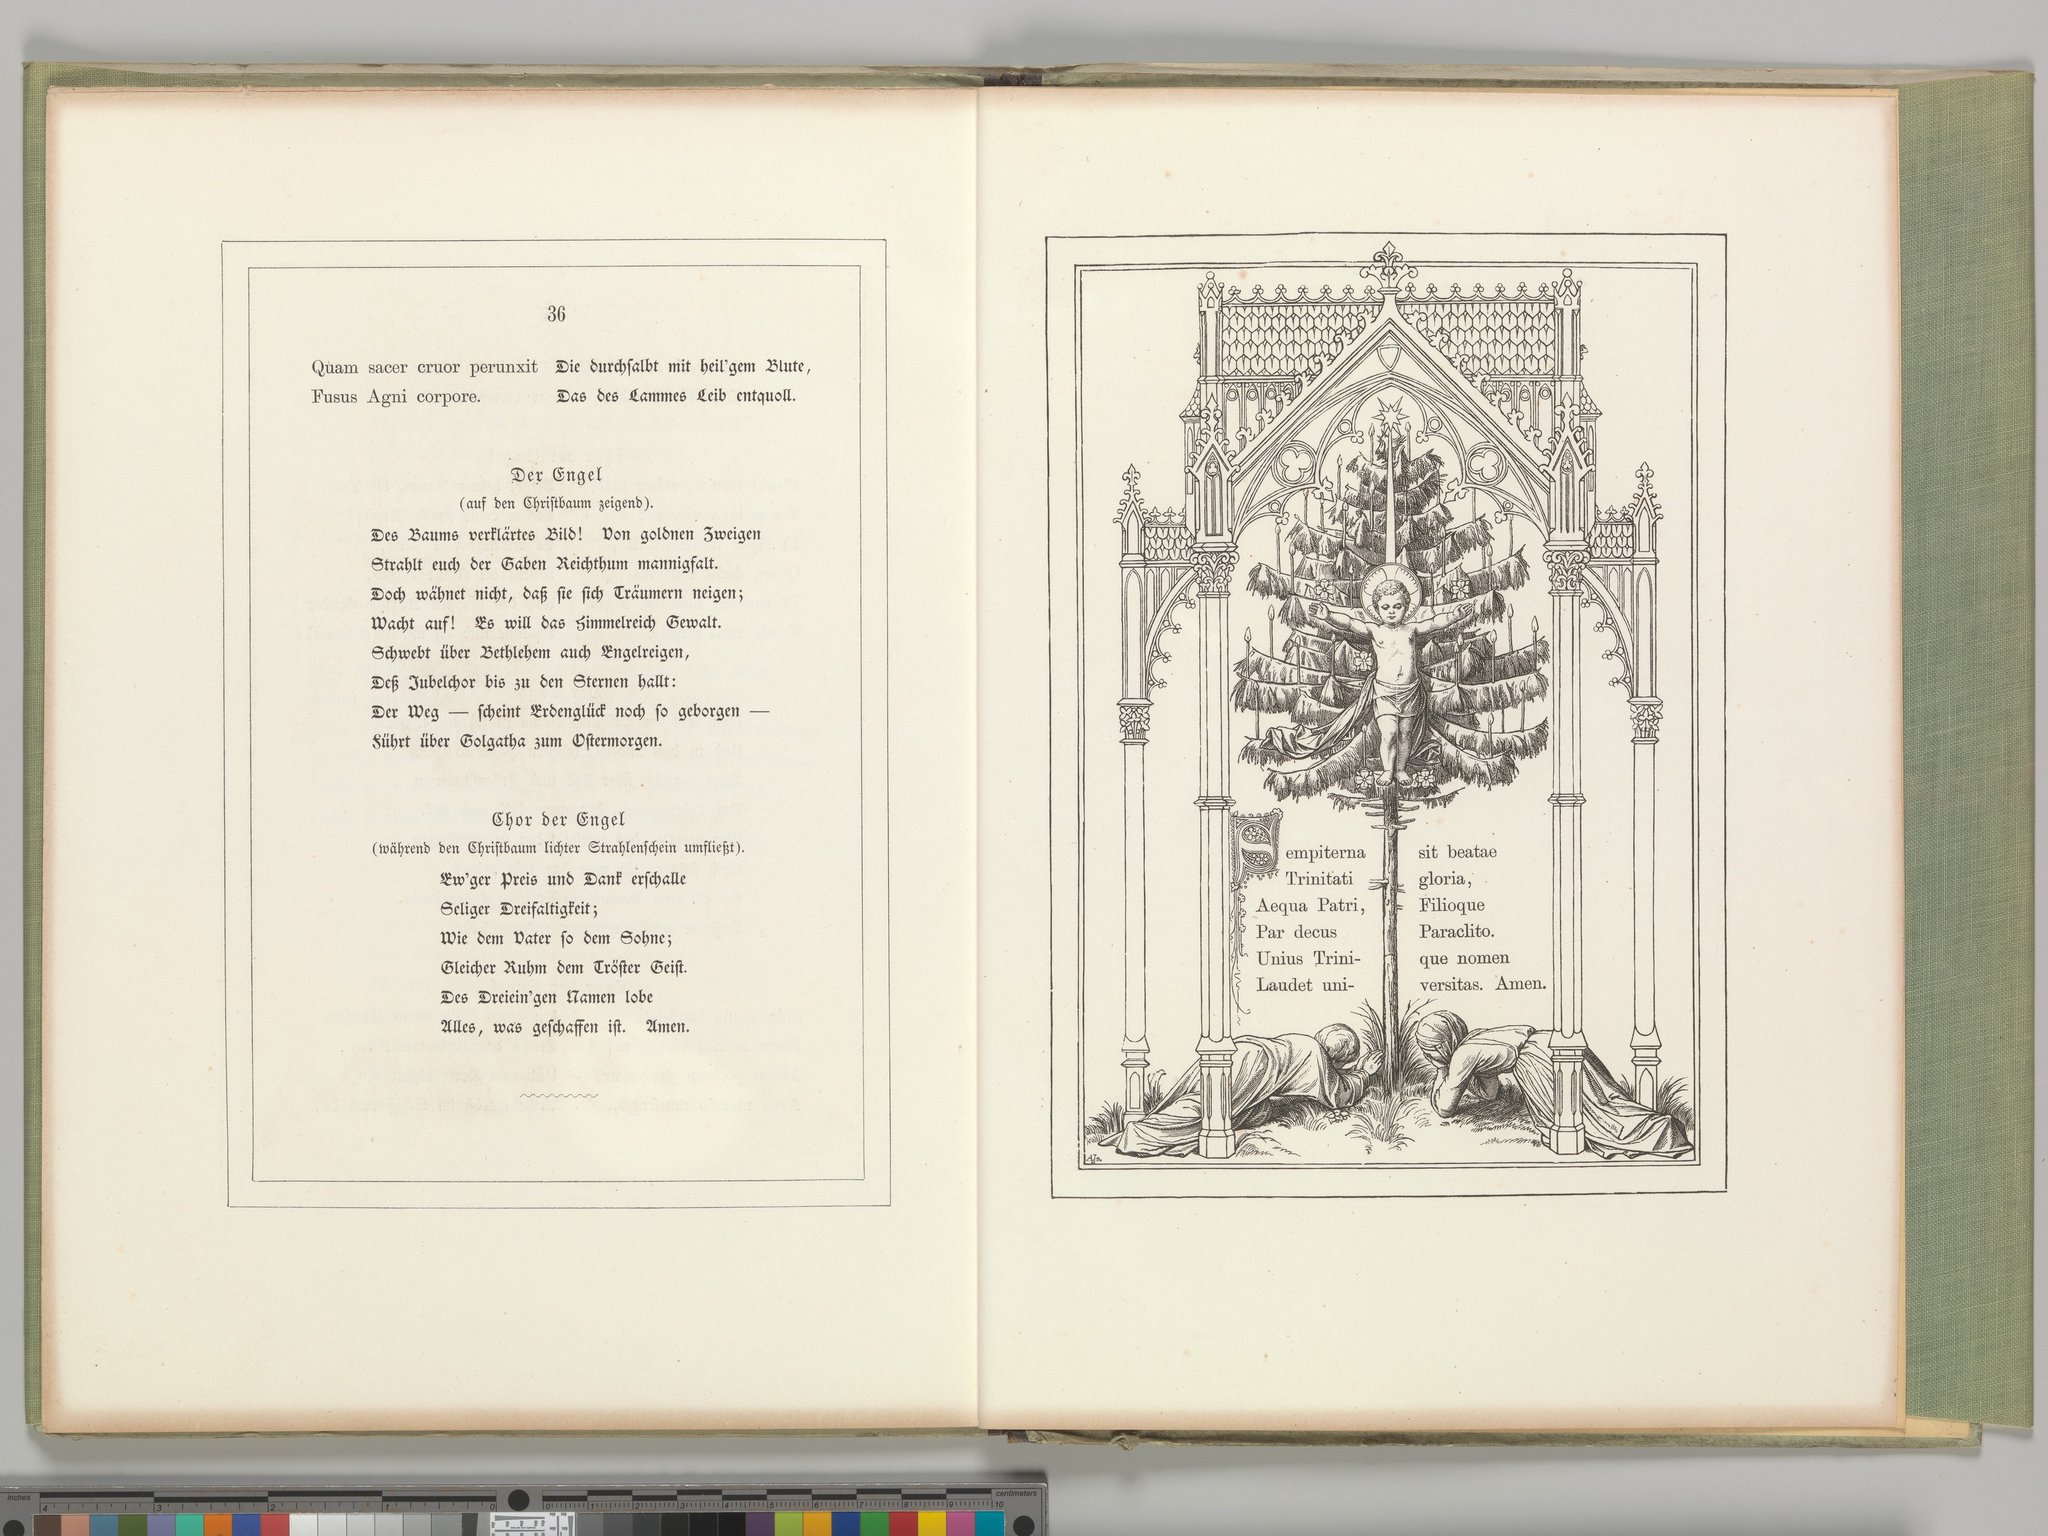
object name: book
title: Weihnachtstraum. Ein Festspiel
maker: wilhelm molitor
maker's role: author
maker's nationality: german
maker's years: 1819-1880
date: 1867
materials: wood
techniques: engraving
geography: germany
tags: christ